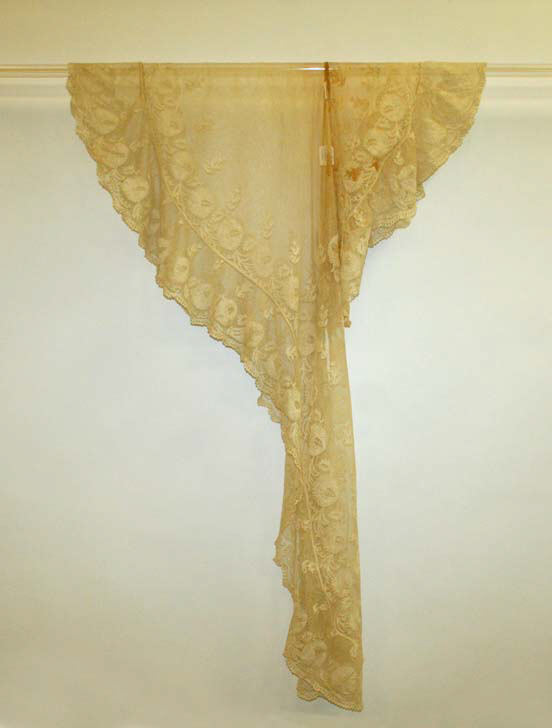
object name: fichu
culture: american or european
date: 1834-1866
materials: cotton